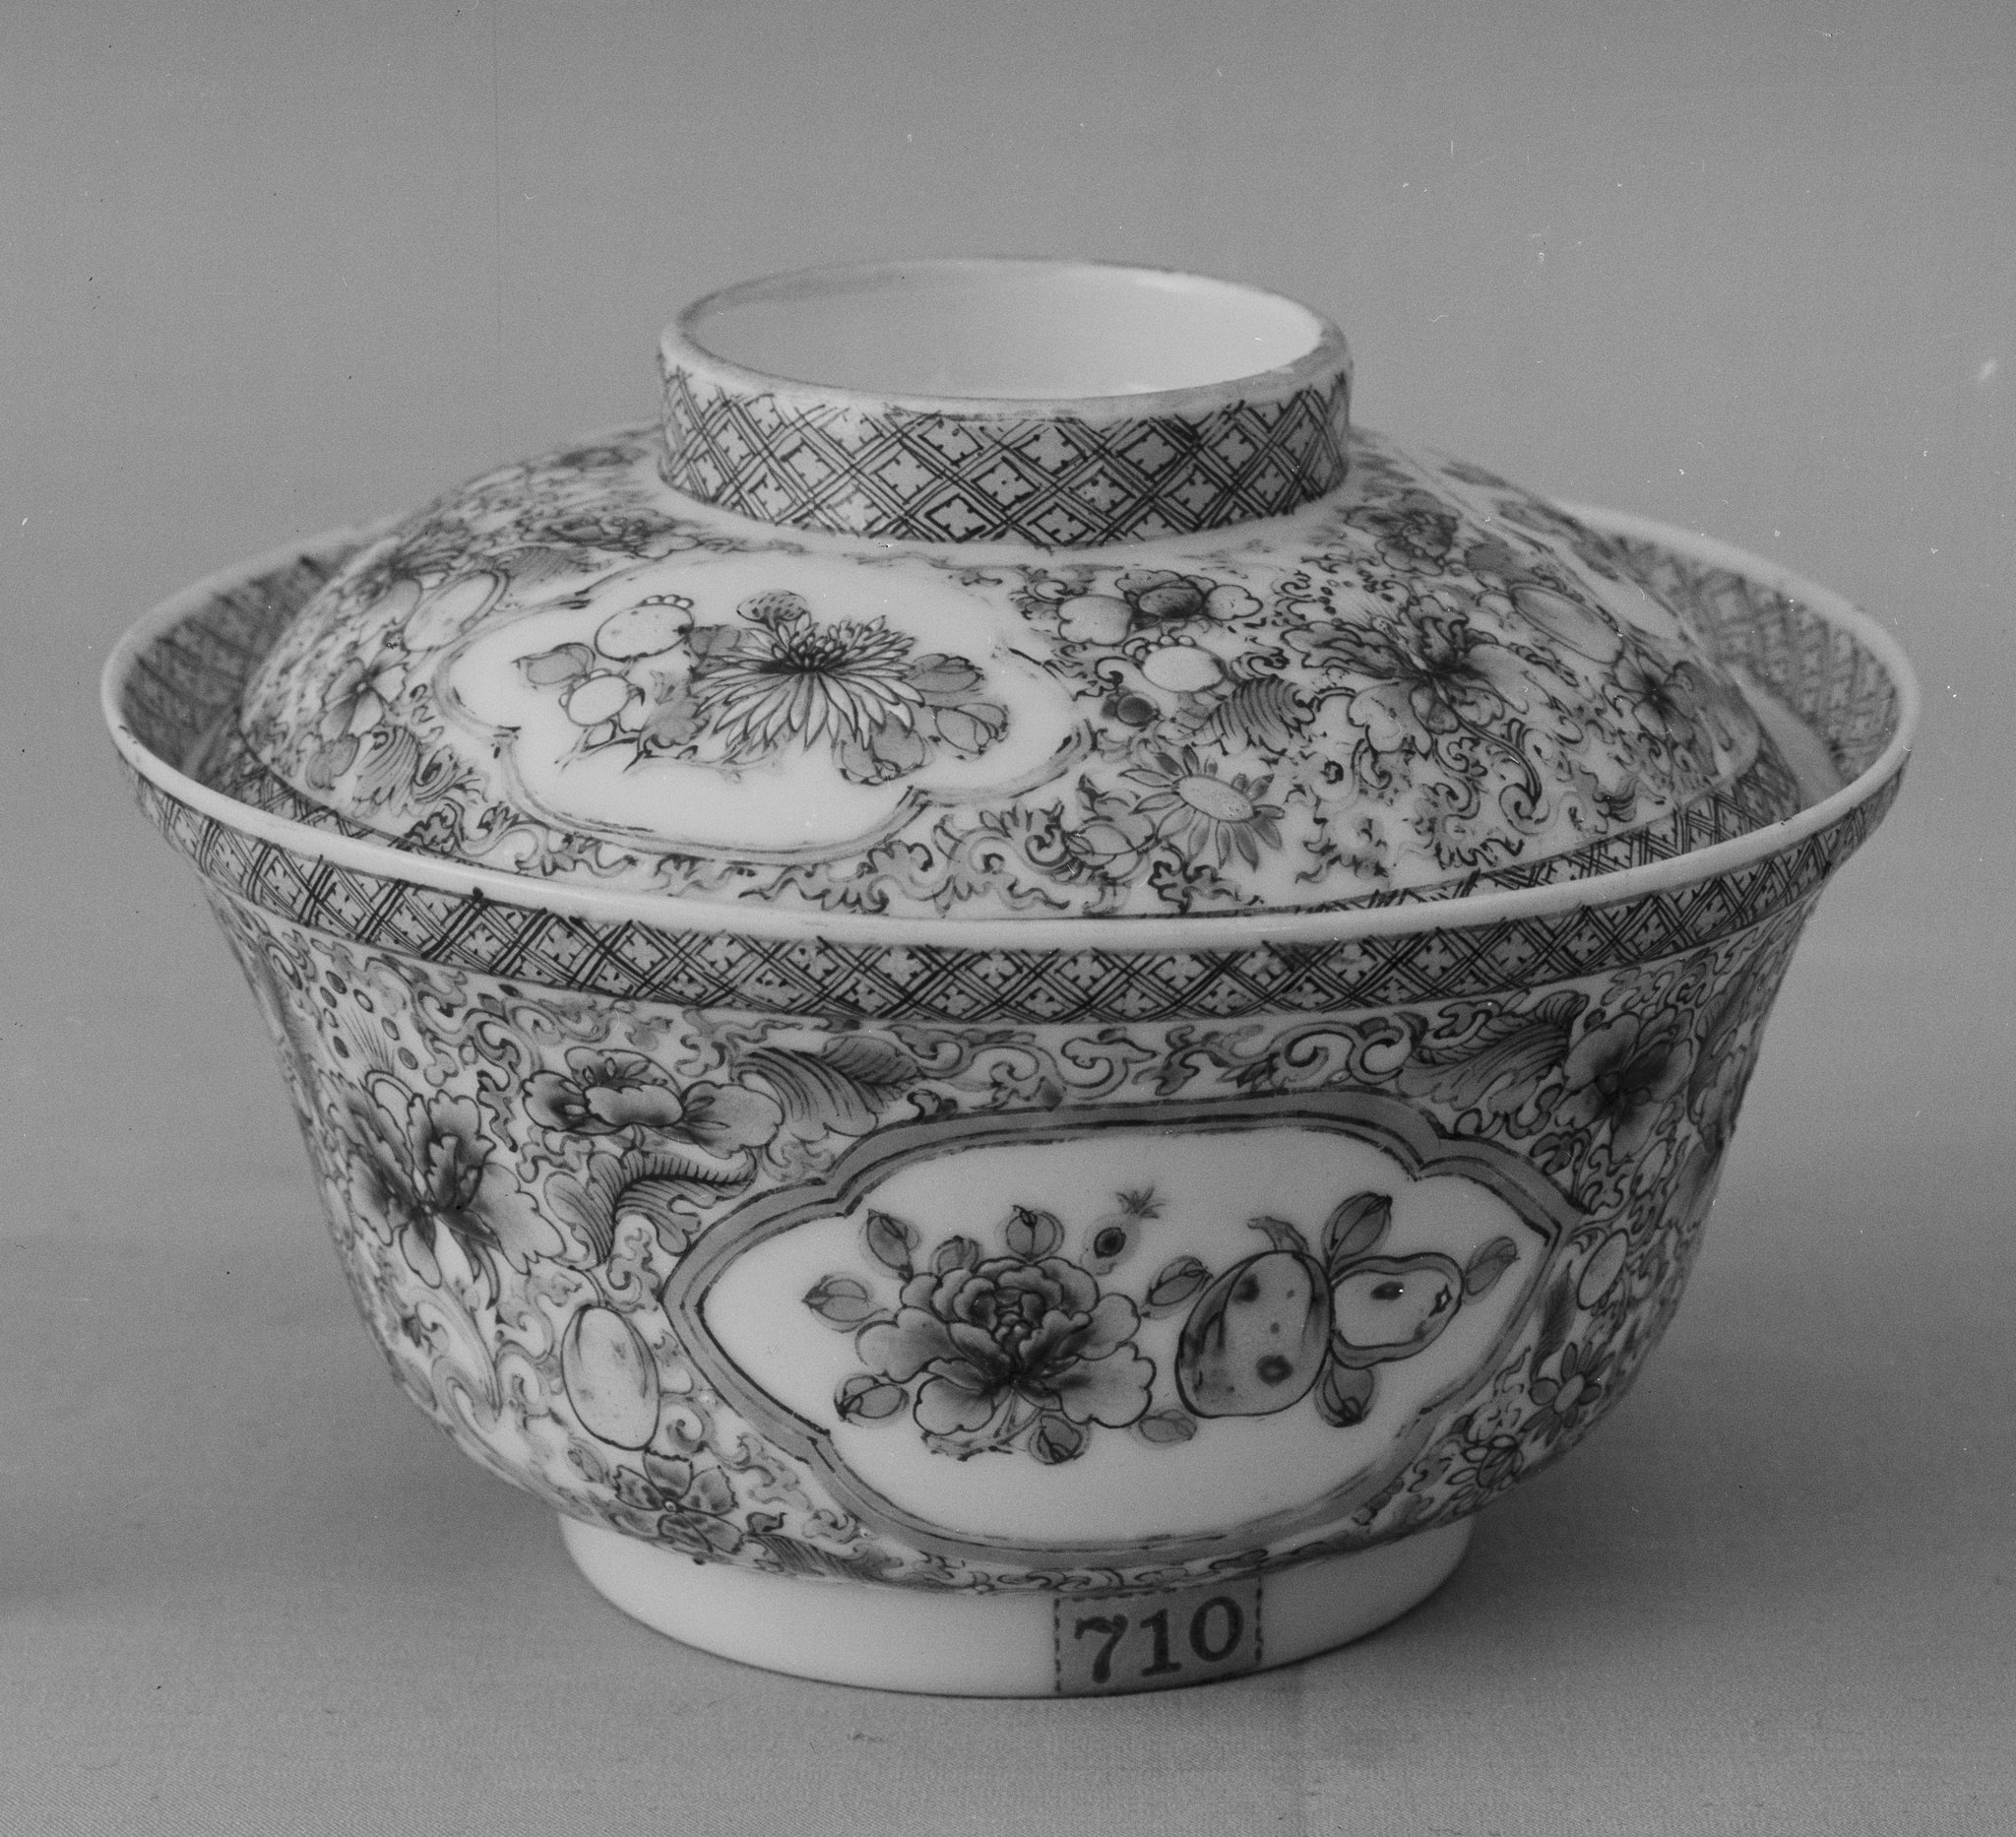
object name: covered bowl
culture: chinese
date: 1723-1750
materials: enamel, porcelain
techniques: overglaze, painting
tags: flowers